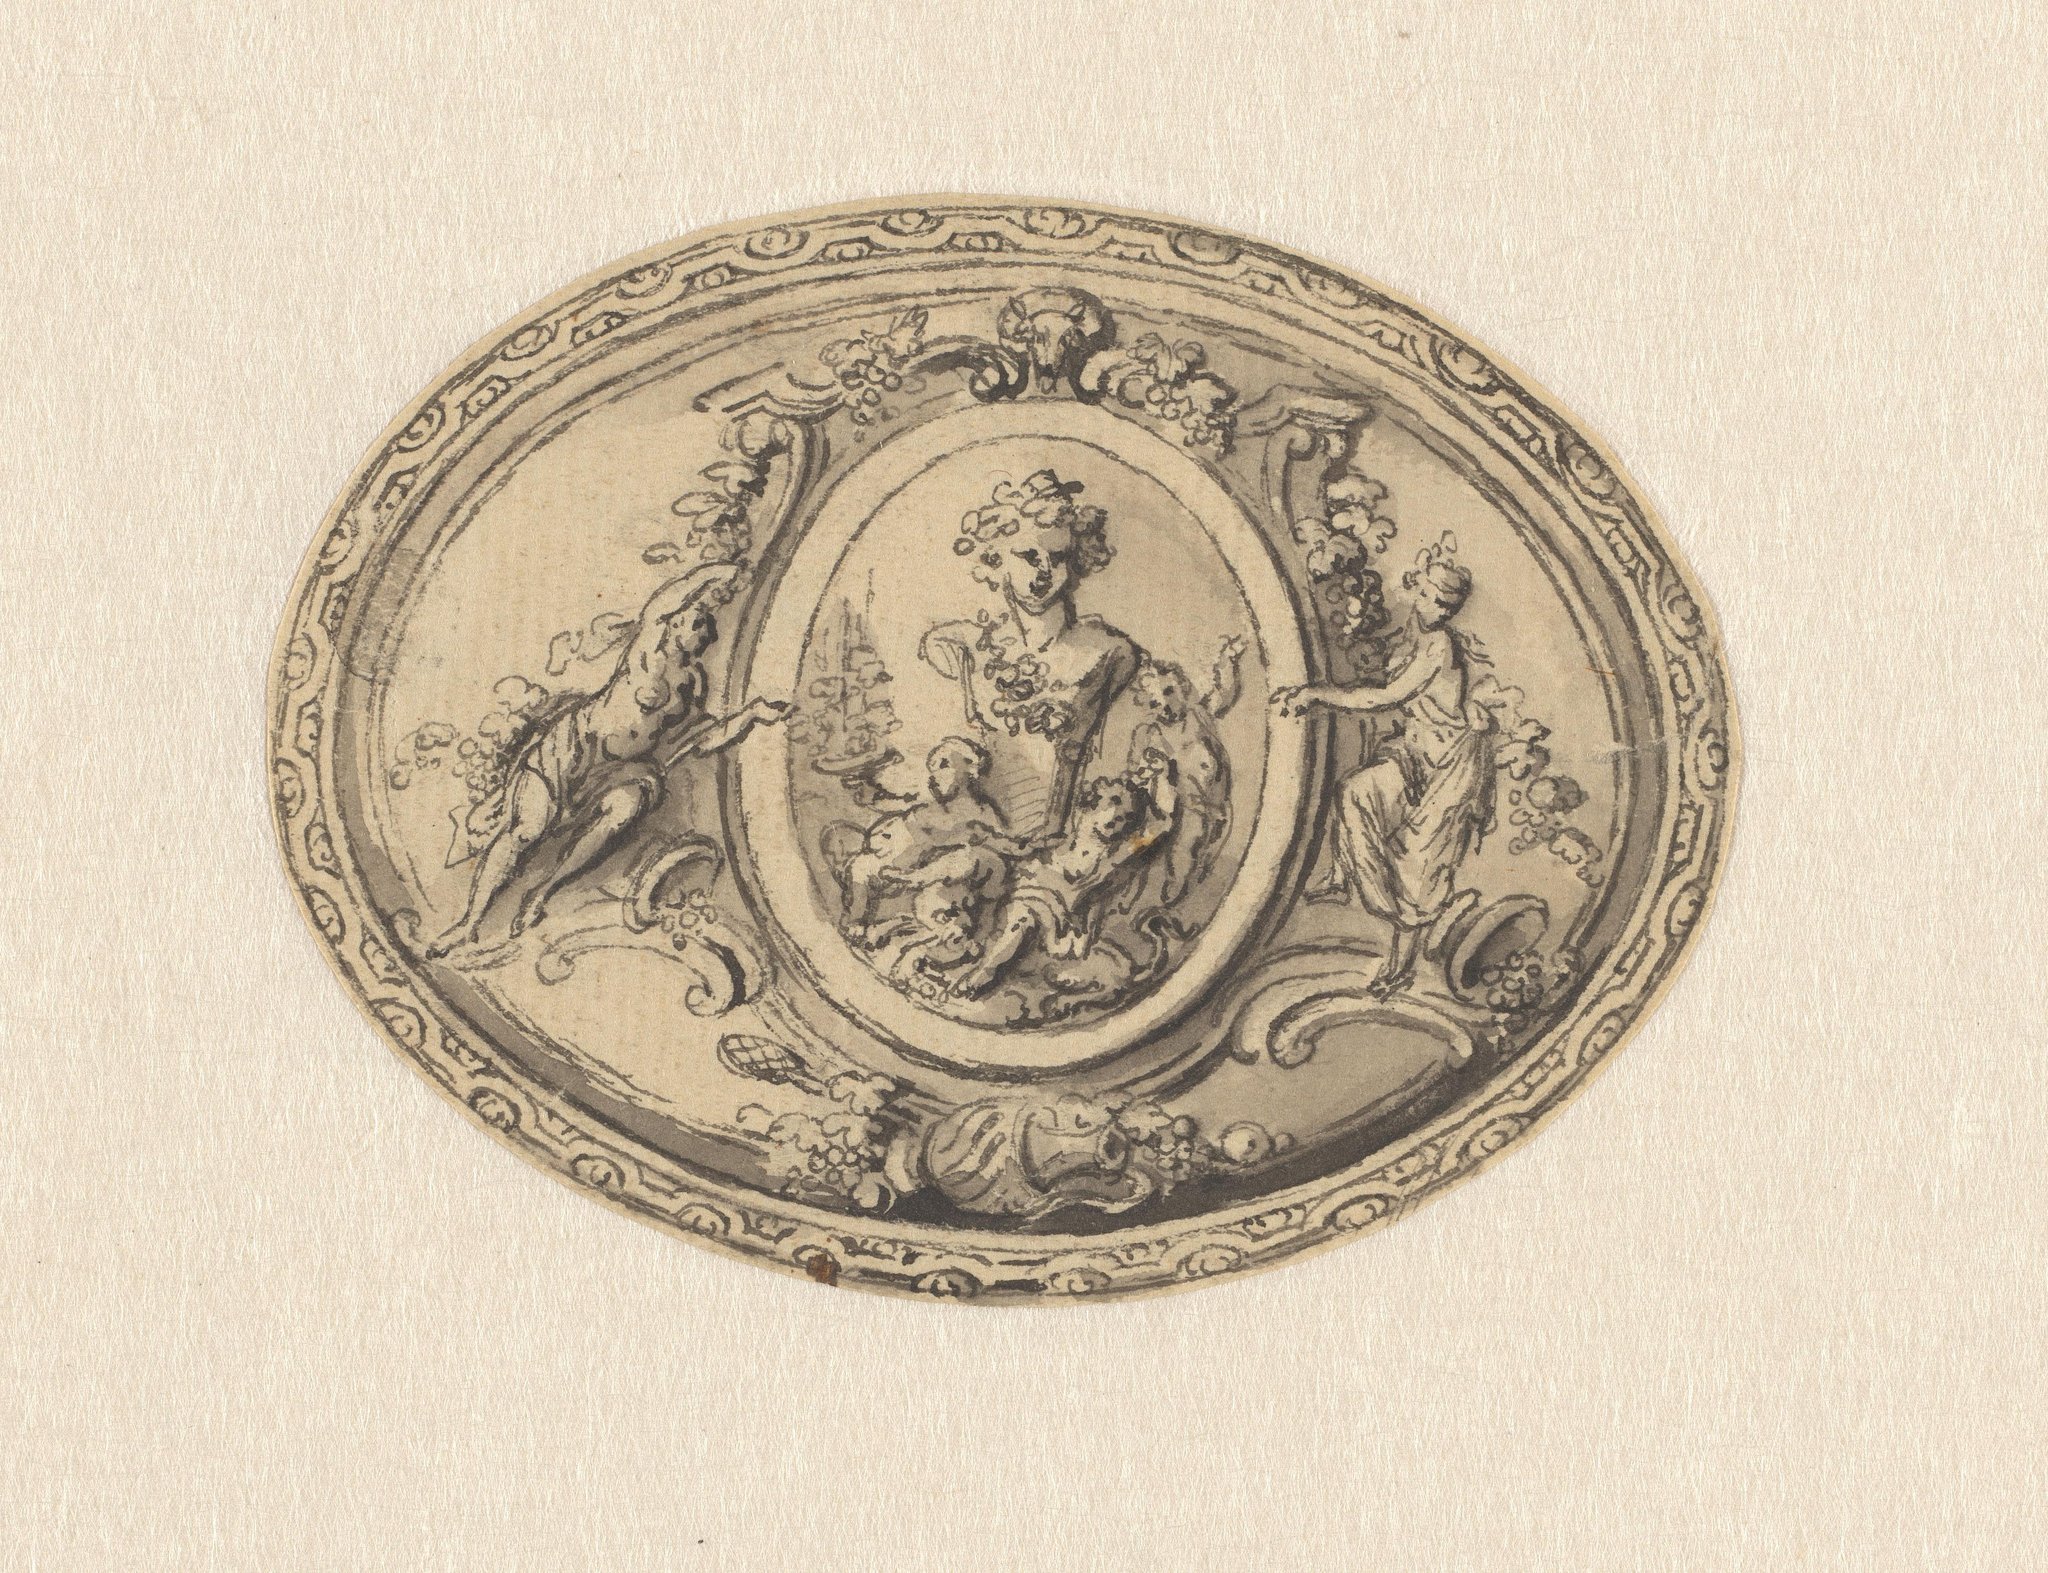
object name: design drawing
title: Snuifdoos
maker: Anonymous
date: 1760-1770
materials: graphite, ink, paper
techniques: brush, pen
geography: paris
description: Ontwerp voor het deksel van een ovale snuifdoos met een buste van Bacchus.